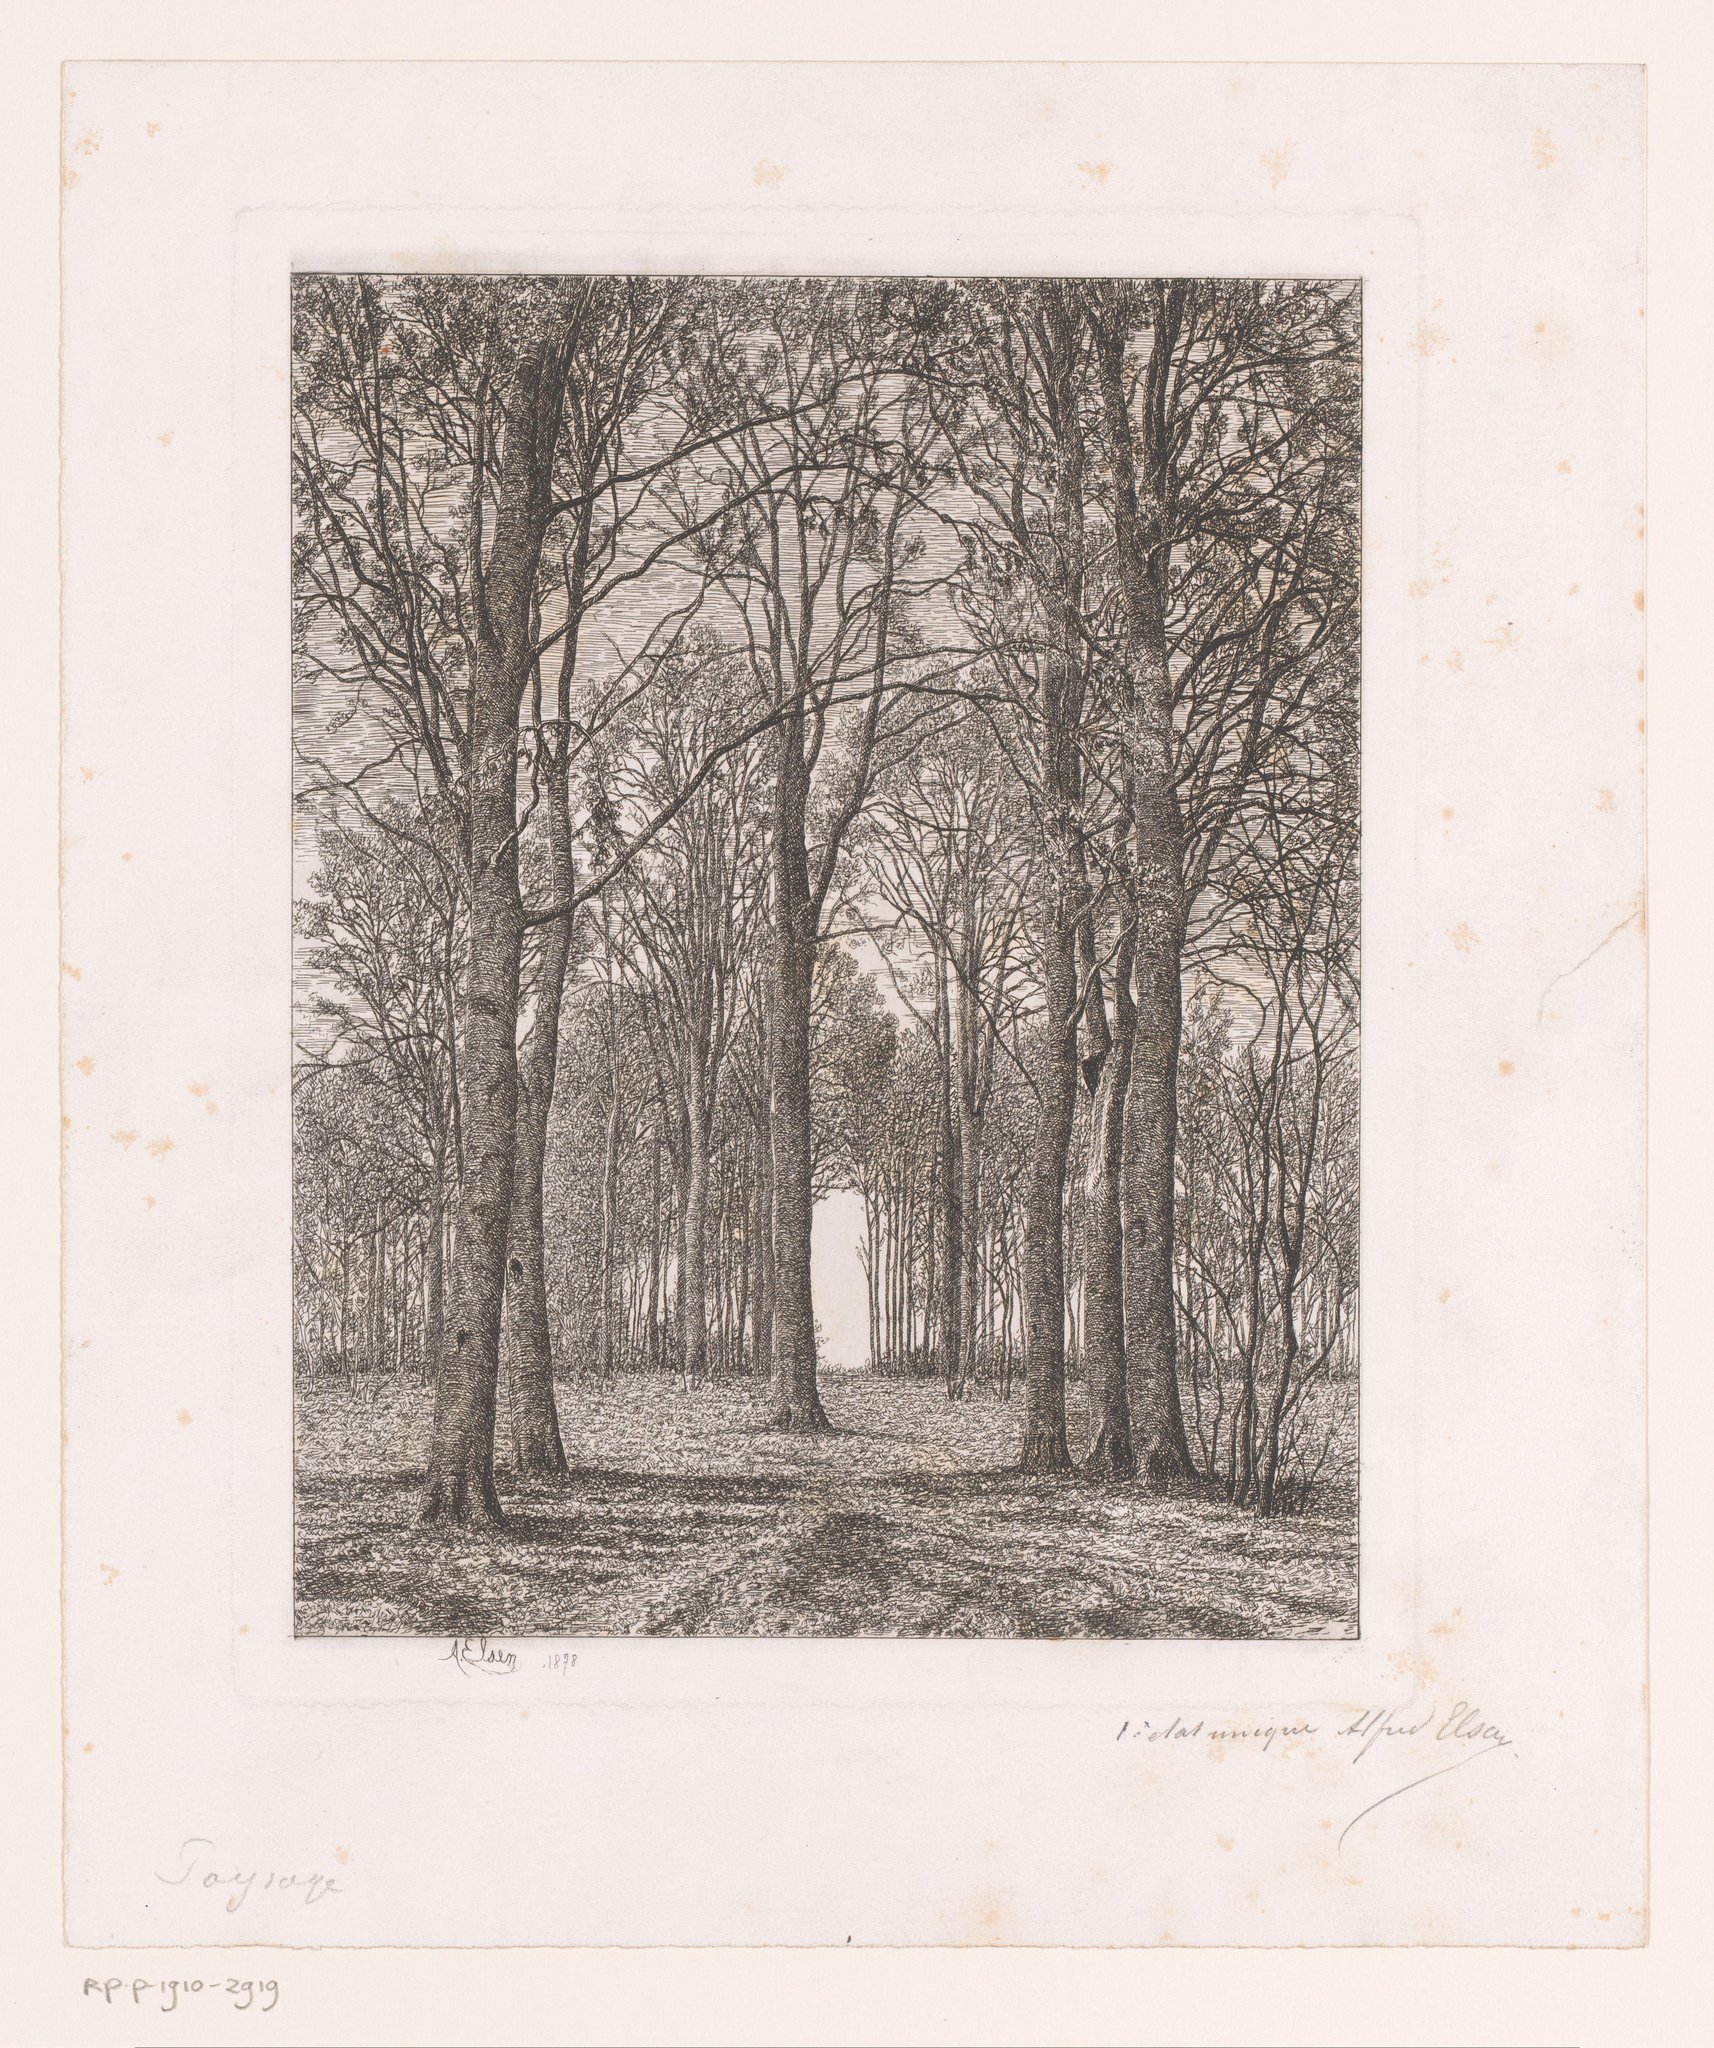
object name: print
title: Landschap met bomen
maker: alfred elsen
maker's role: painter, print maker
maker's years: 1850-1914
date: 1878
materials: paper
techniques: etching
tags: trees, forest, wood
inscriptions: inscription: ‘1e etat unique’, collector's mark: Lugt 2228